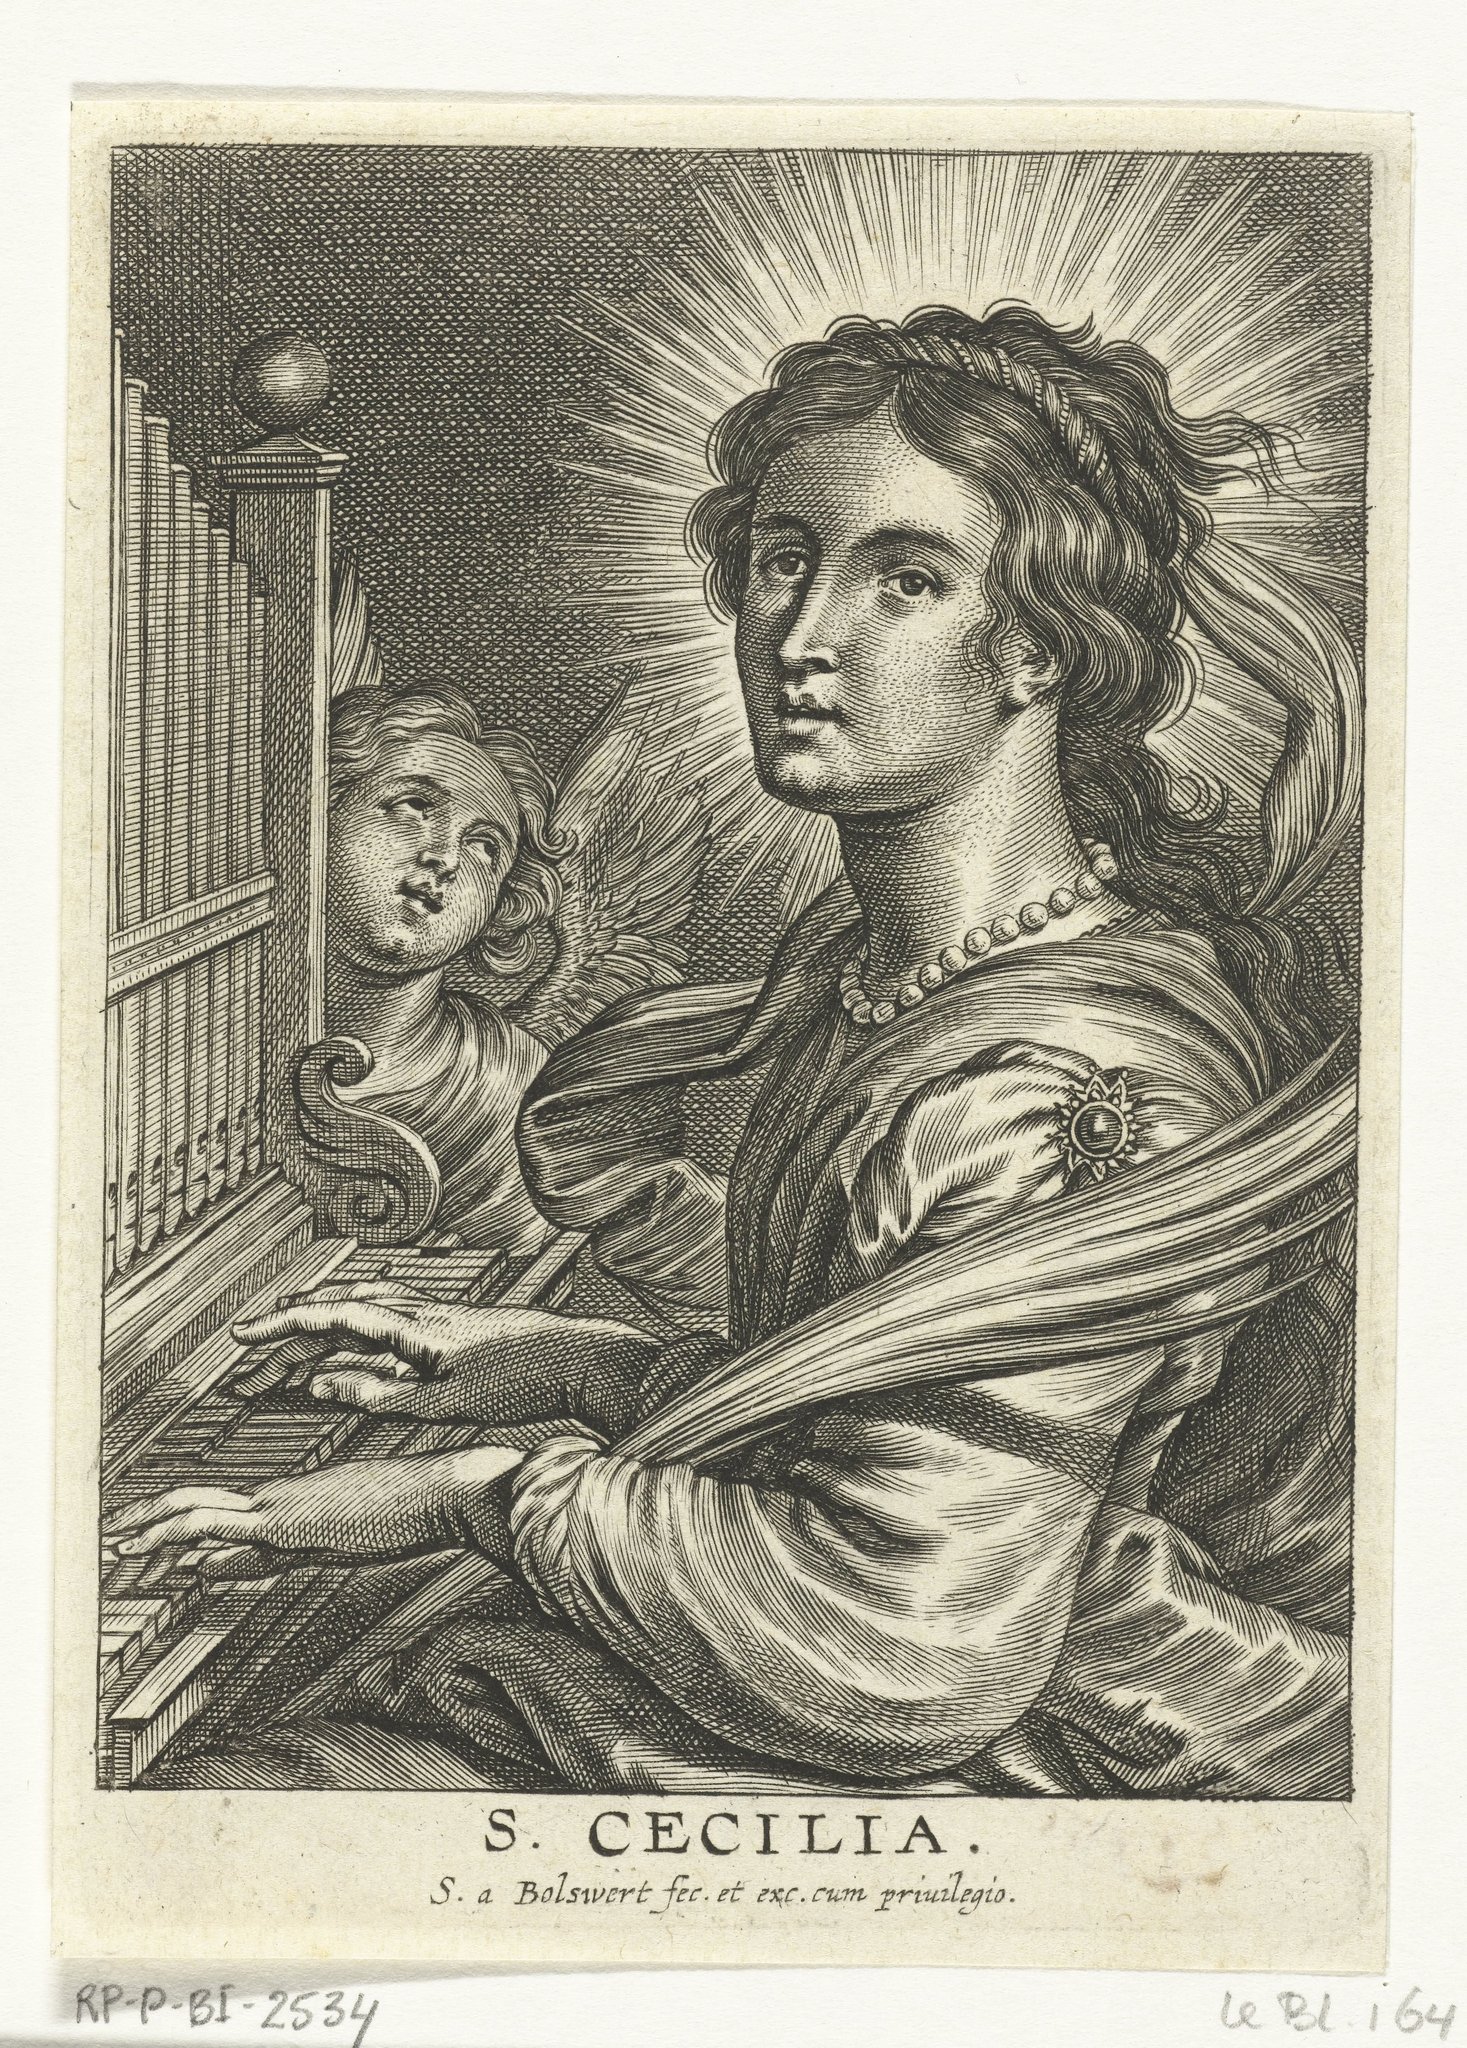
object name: print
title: Heilige Cecilia met orgel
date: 1596-1659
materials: paper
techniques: engraving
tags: the virgin martyr cecilia of rome; possible attributes: falcon, musical instruments, organ, wreath of roses and lilies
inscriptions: collector's mark: Lugt 240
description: Prent naar ontwerp van Peter Paul Rubens.